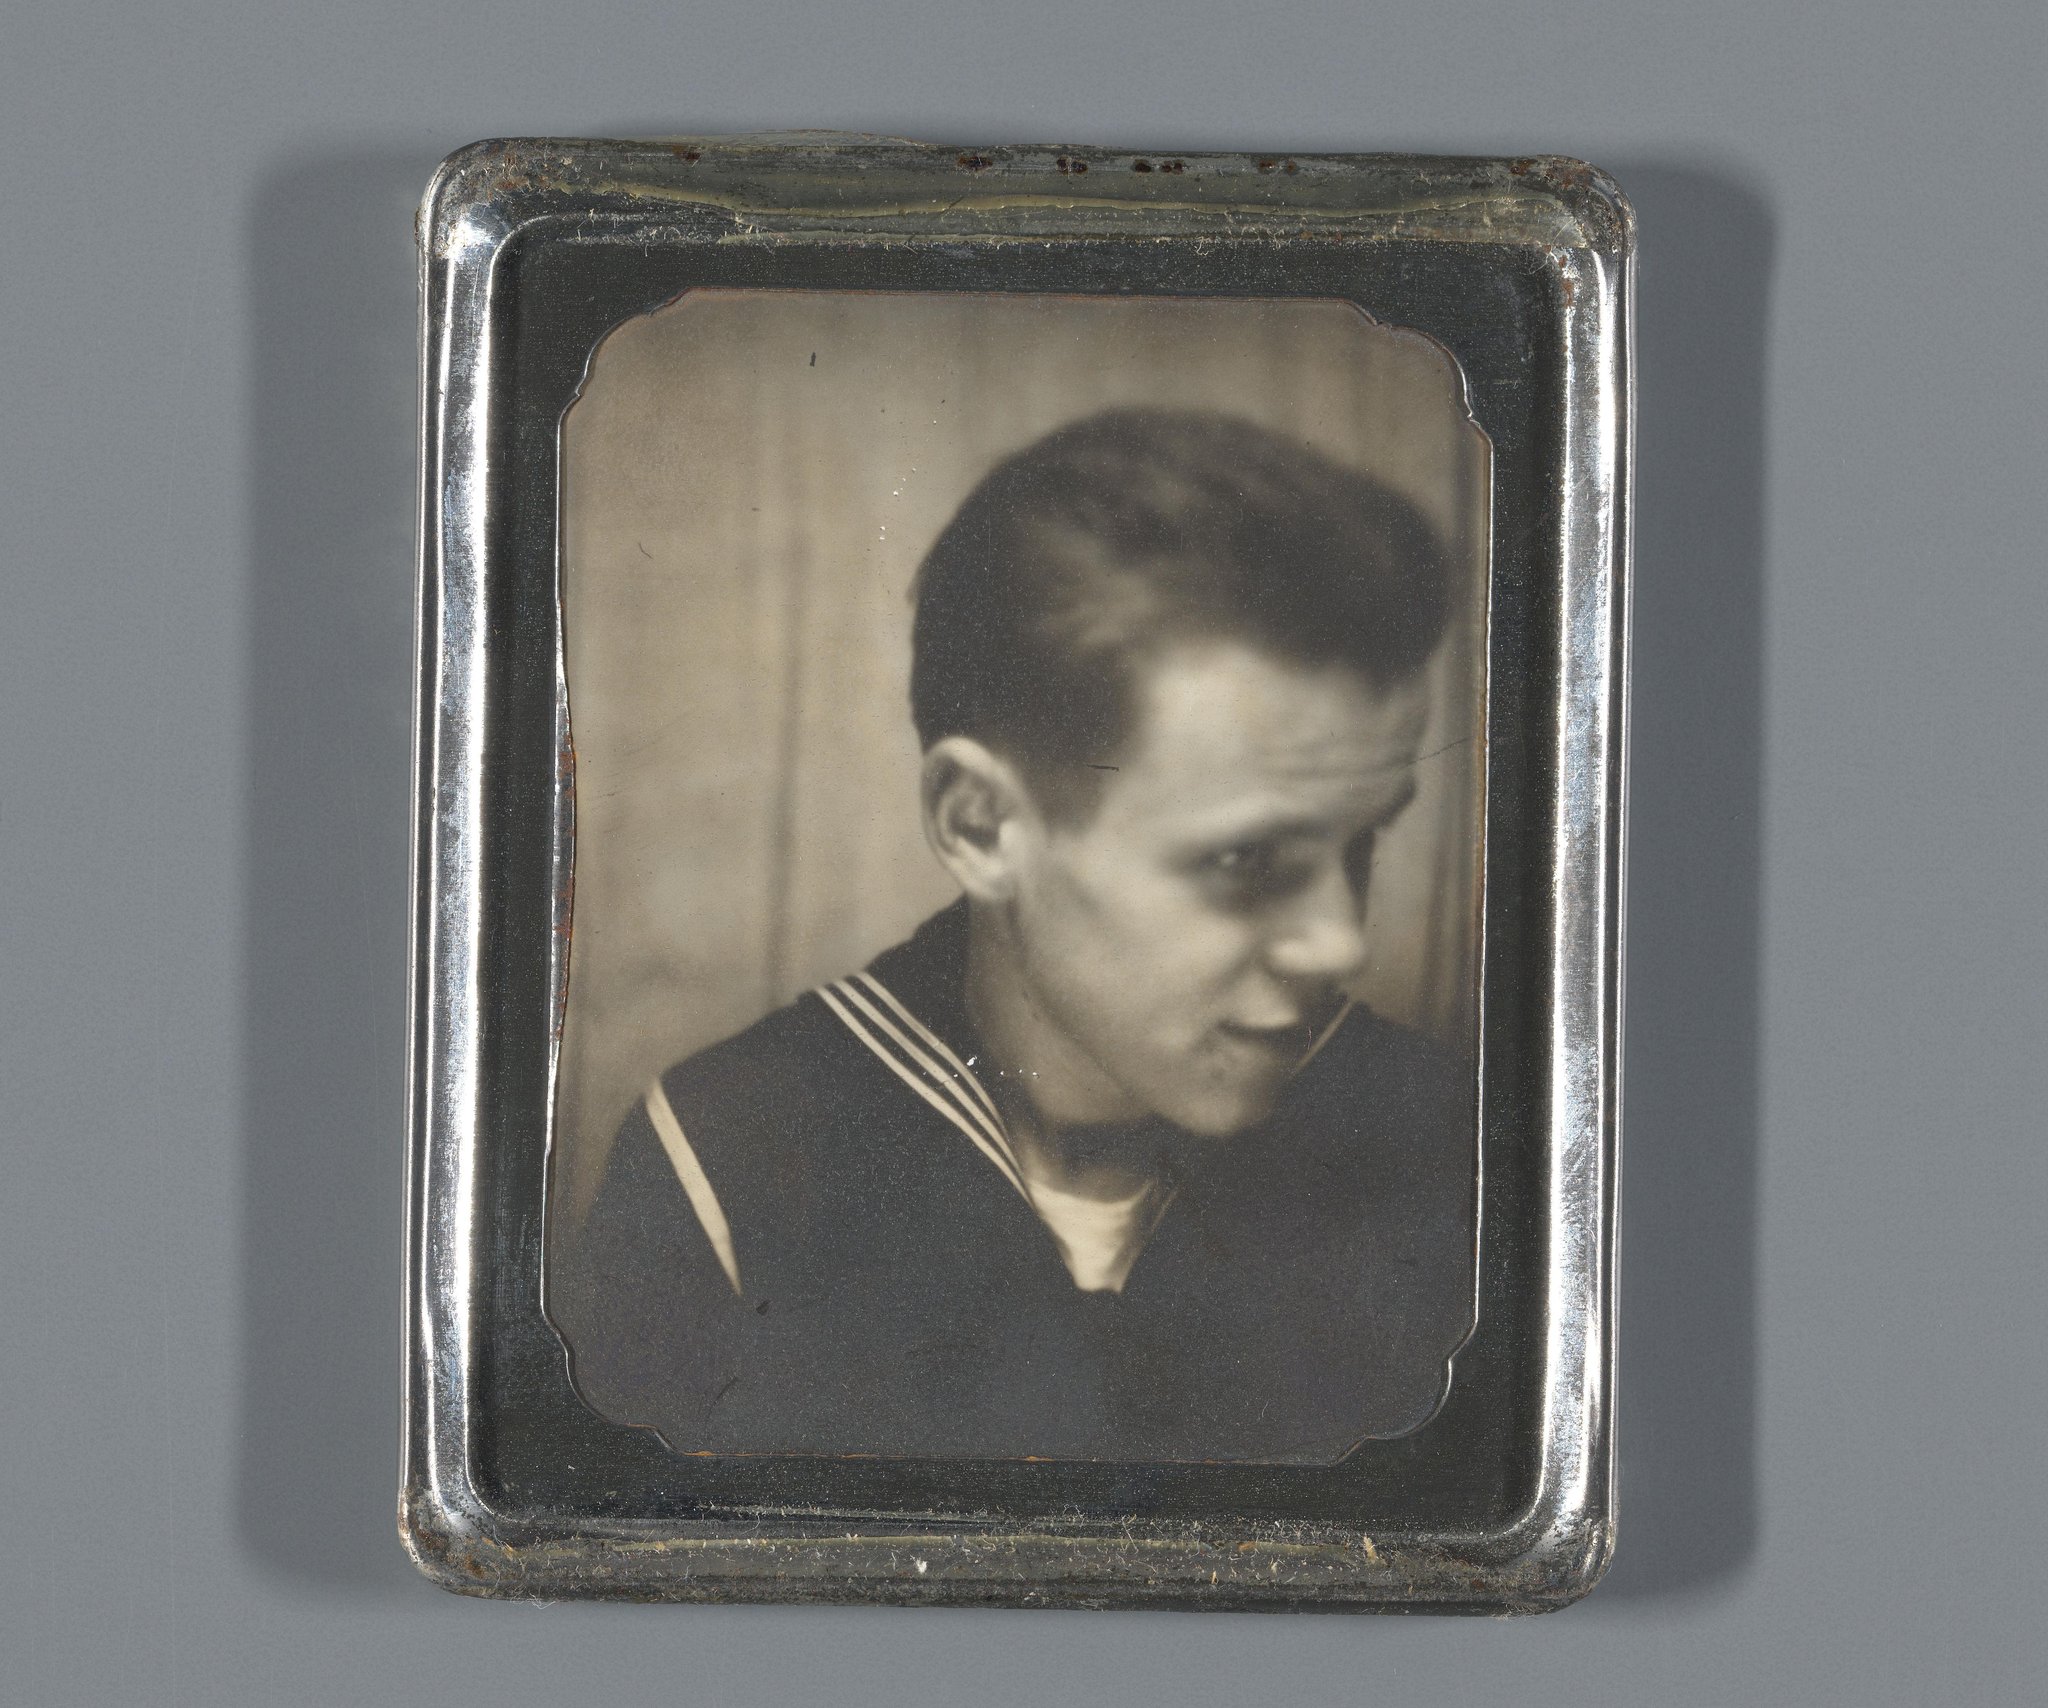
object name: photograph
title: William Swanson, matroos, Newport, R.I., 1944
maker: Anonymous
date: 1944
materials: photographic support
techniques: gelatin silver print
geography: united states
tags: militair, william swanson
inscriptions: inscription: ‘IDENTIFICATION / NAME [op RP-F-2022-57-7 ingevuld maar onleesbaar] / Street / City [in pen: Newport, R.I.] / EMPLOYED BY [op RP-F-2022-57-7 ingevuld maar onleesbaar] / Mfg. by / POSITIVE PAPER / AND CHEMICAL CO., Inc. / 30 Clifton St., Newark, N. J.’, date: ‘10-13-44’